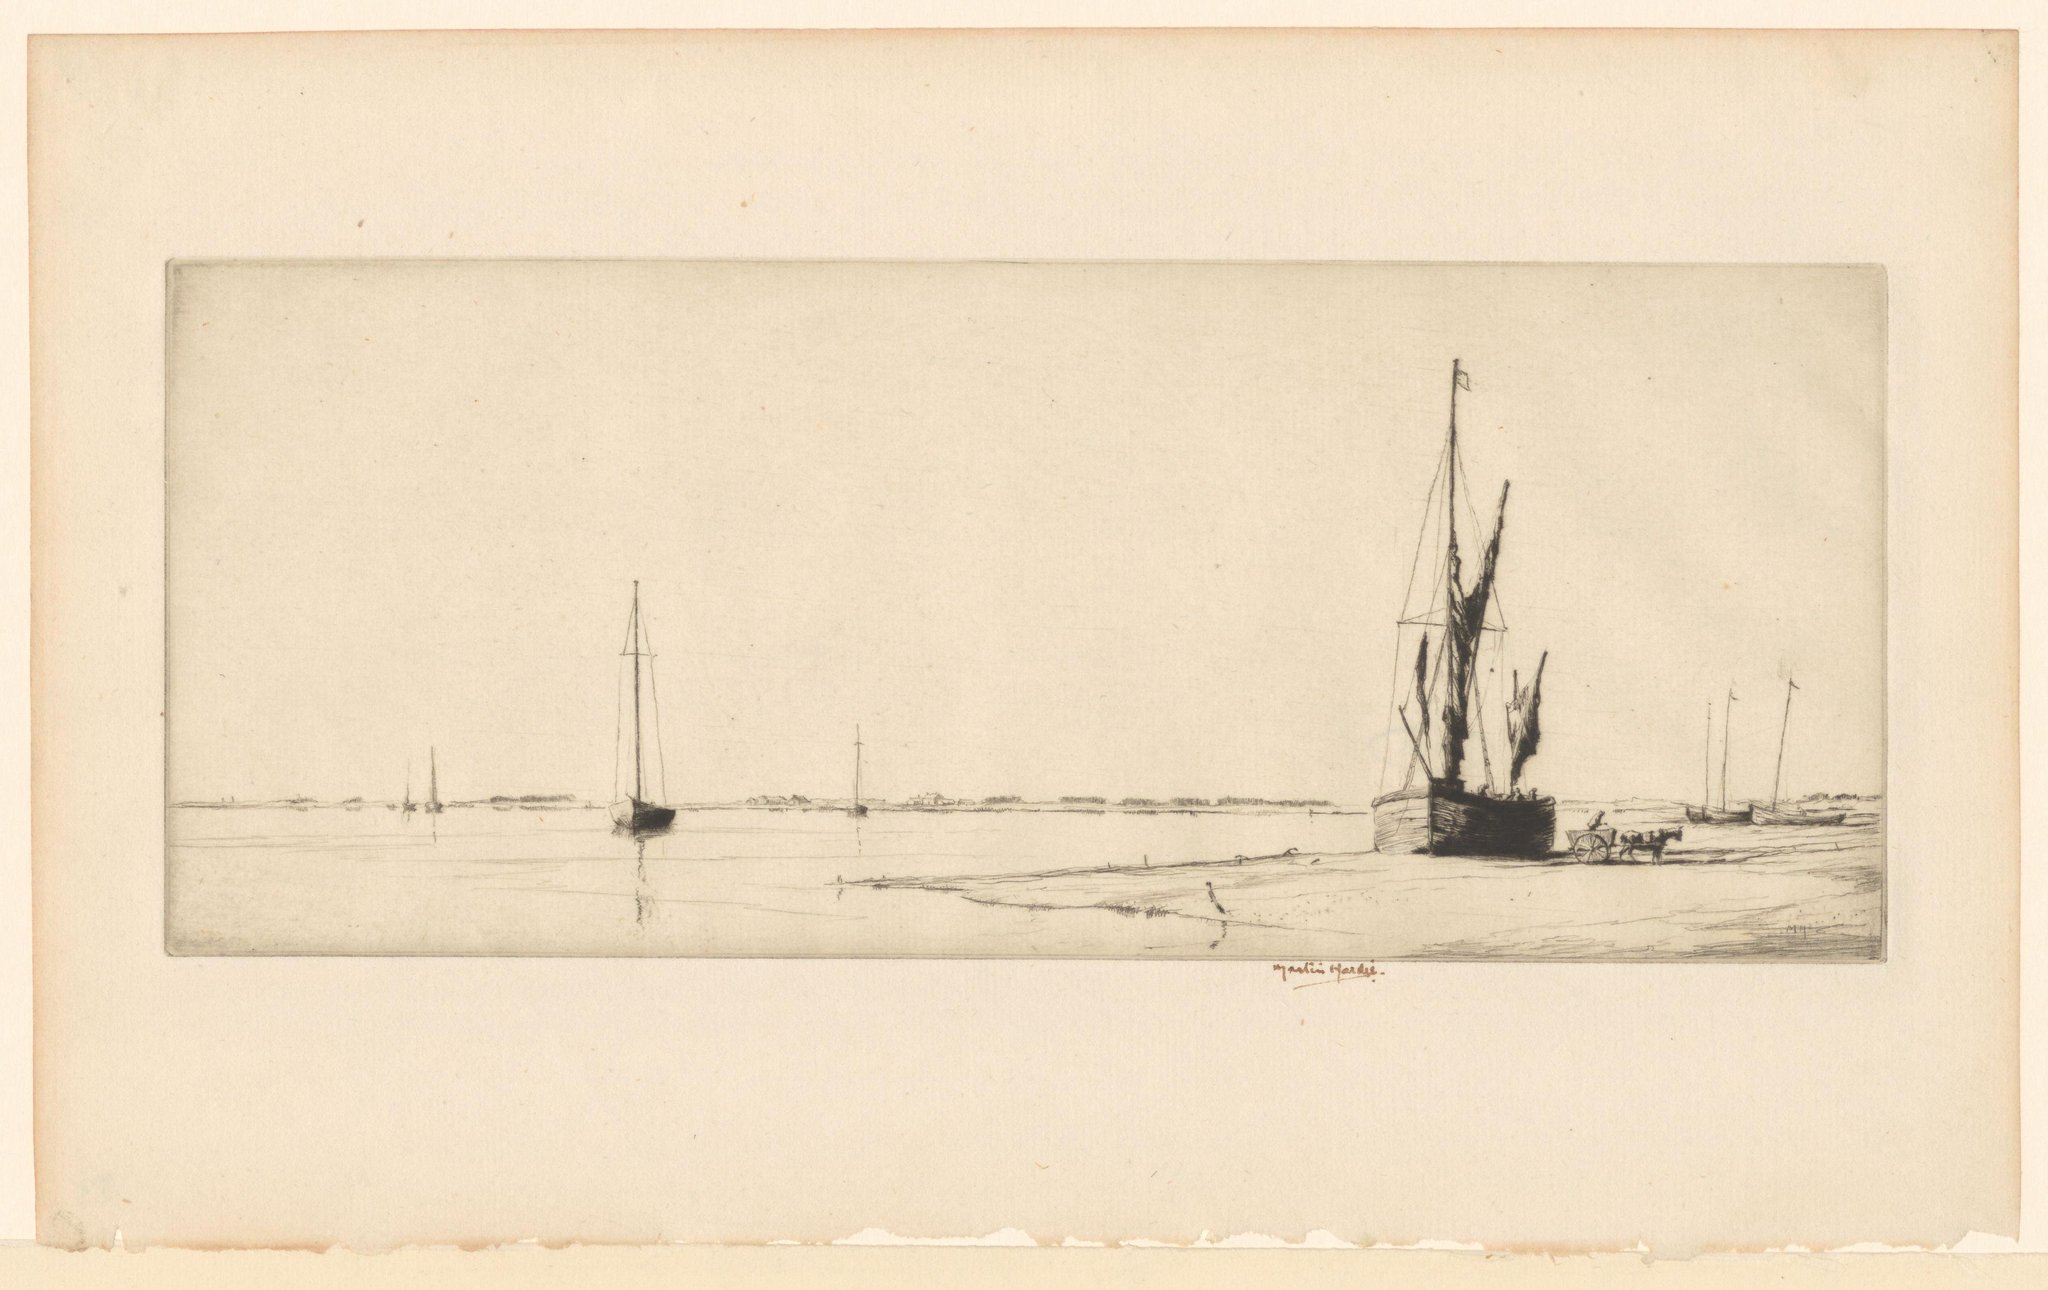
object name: print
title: Gezicht op de Heybridge Basin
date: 1923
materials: paper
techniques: drypoint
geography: maldon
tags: harbouring, (farm) wagon, freight wagon, cart, coast (+ landscape with figures, staffage)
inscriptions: annotation: ‘Martin Hardie’, collector's mark: Lugt 2228, collector's mark: Lugt 2760